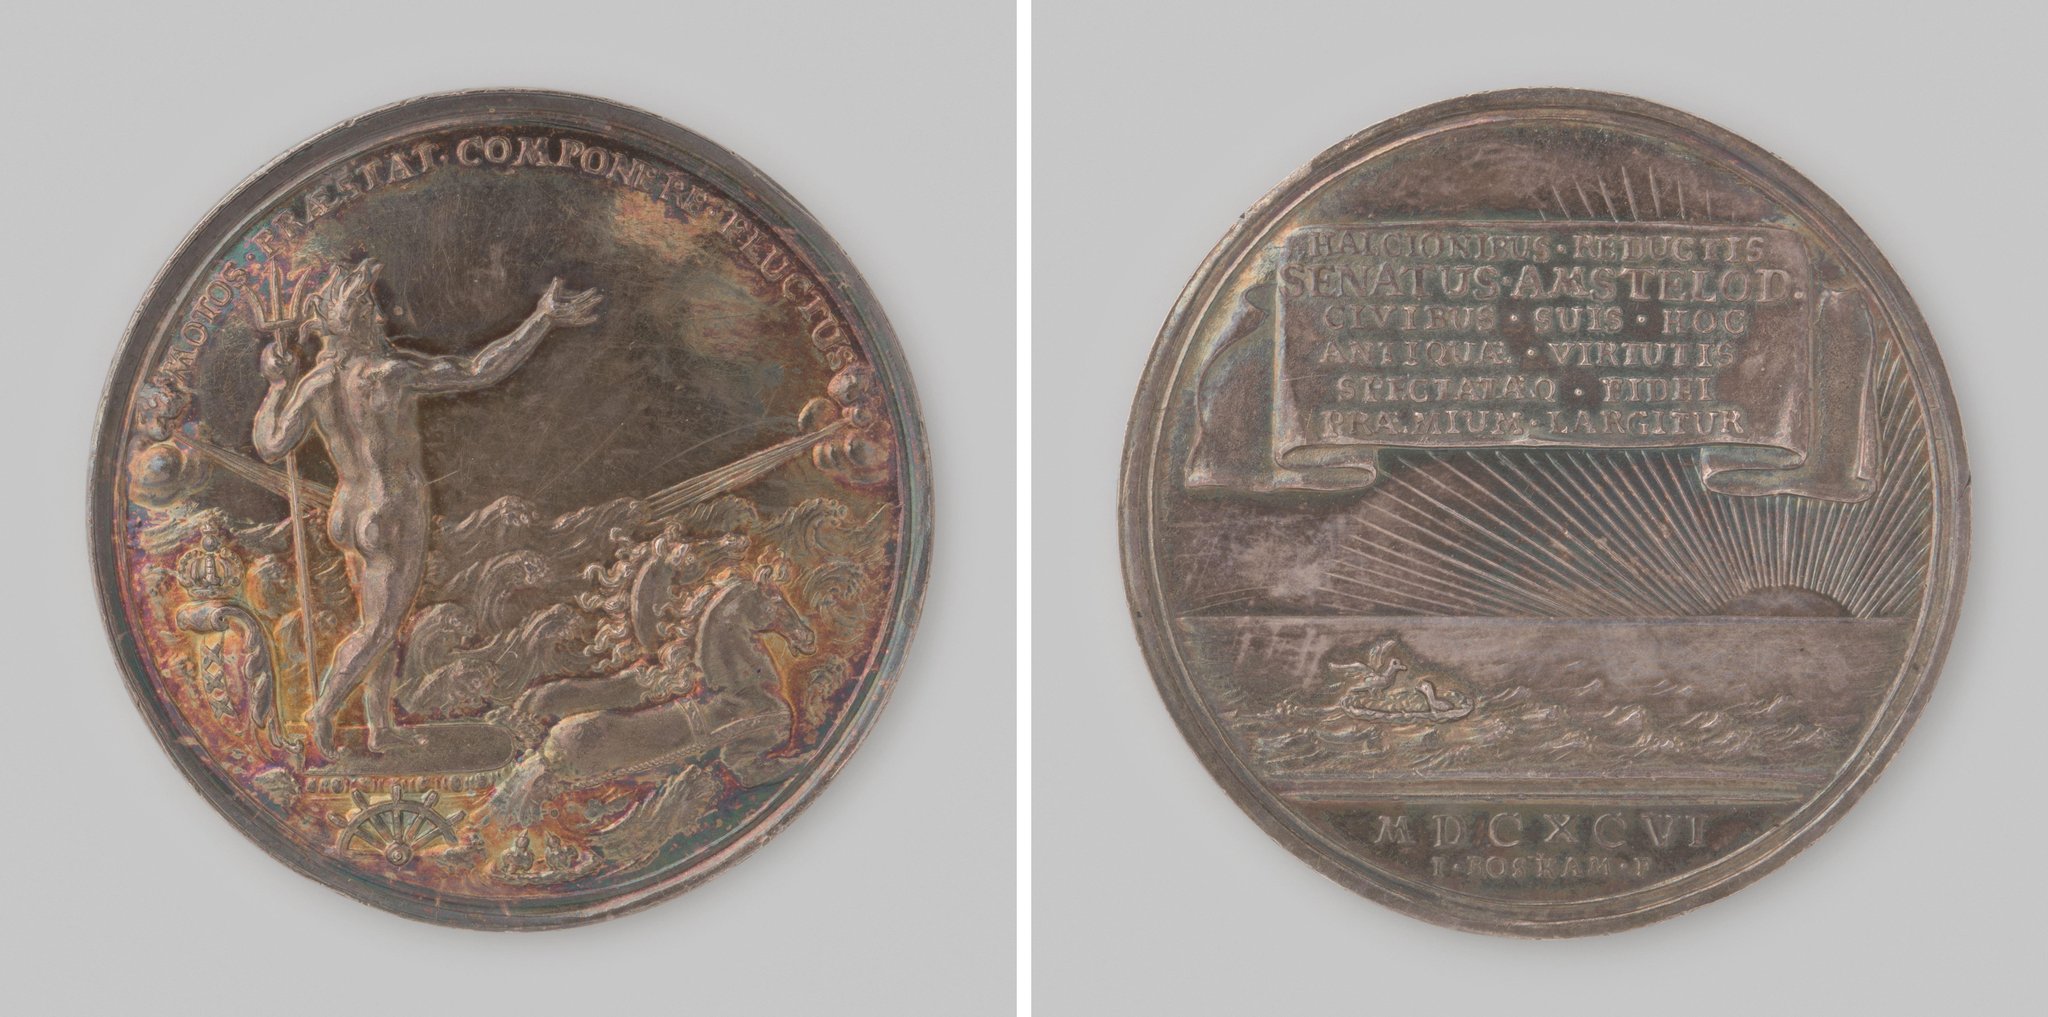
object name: history medal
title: Beloningspenning voor het neerslaan van het aansprekersoproer in Amsterdam 1696 (middelgroot model)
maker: jan boskam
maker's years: 1687-1708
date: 1696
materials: silver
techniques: striking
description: Zilveren penning, op de voorzijde Neptunus in strijdwagen op zee tussen twee windgoden, met omschrift, op de keerzijde een vredige zee waarop een vogelnest, met bovenaan een tekstvlag en in afsnede XDCXCVI / I. BOSKAM F